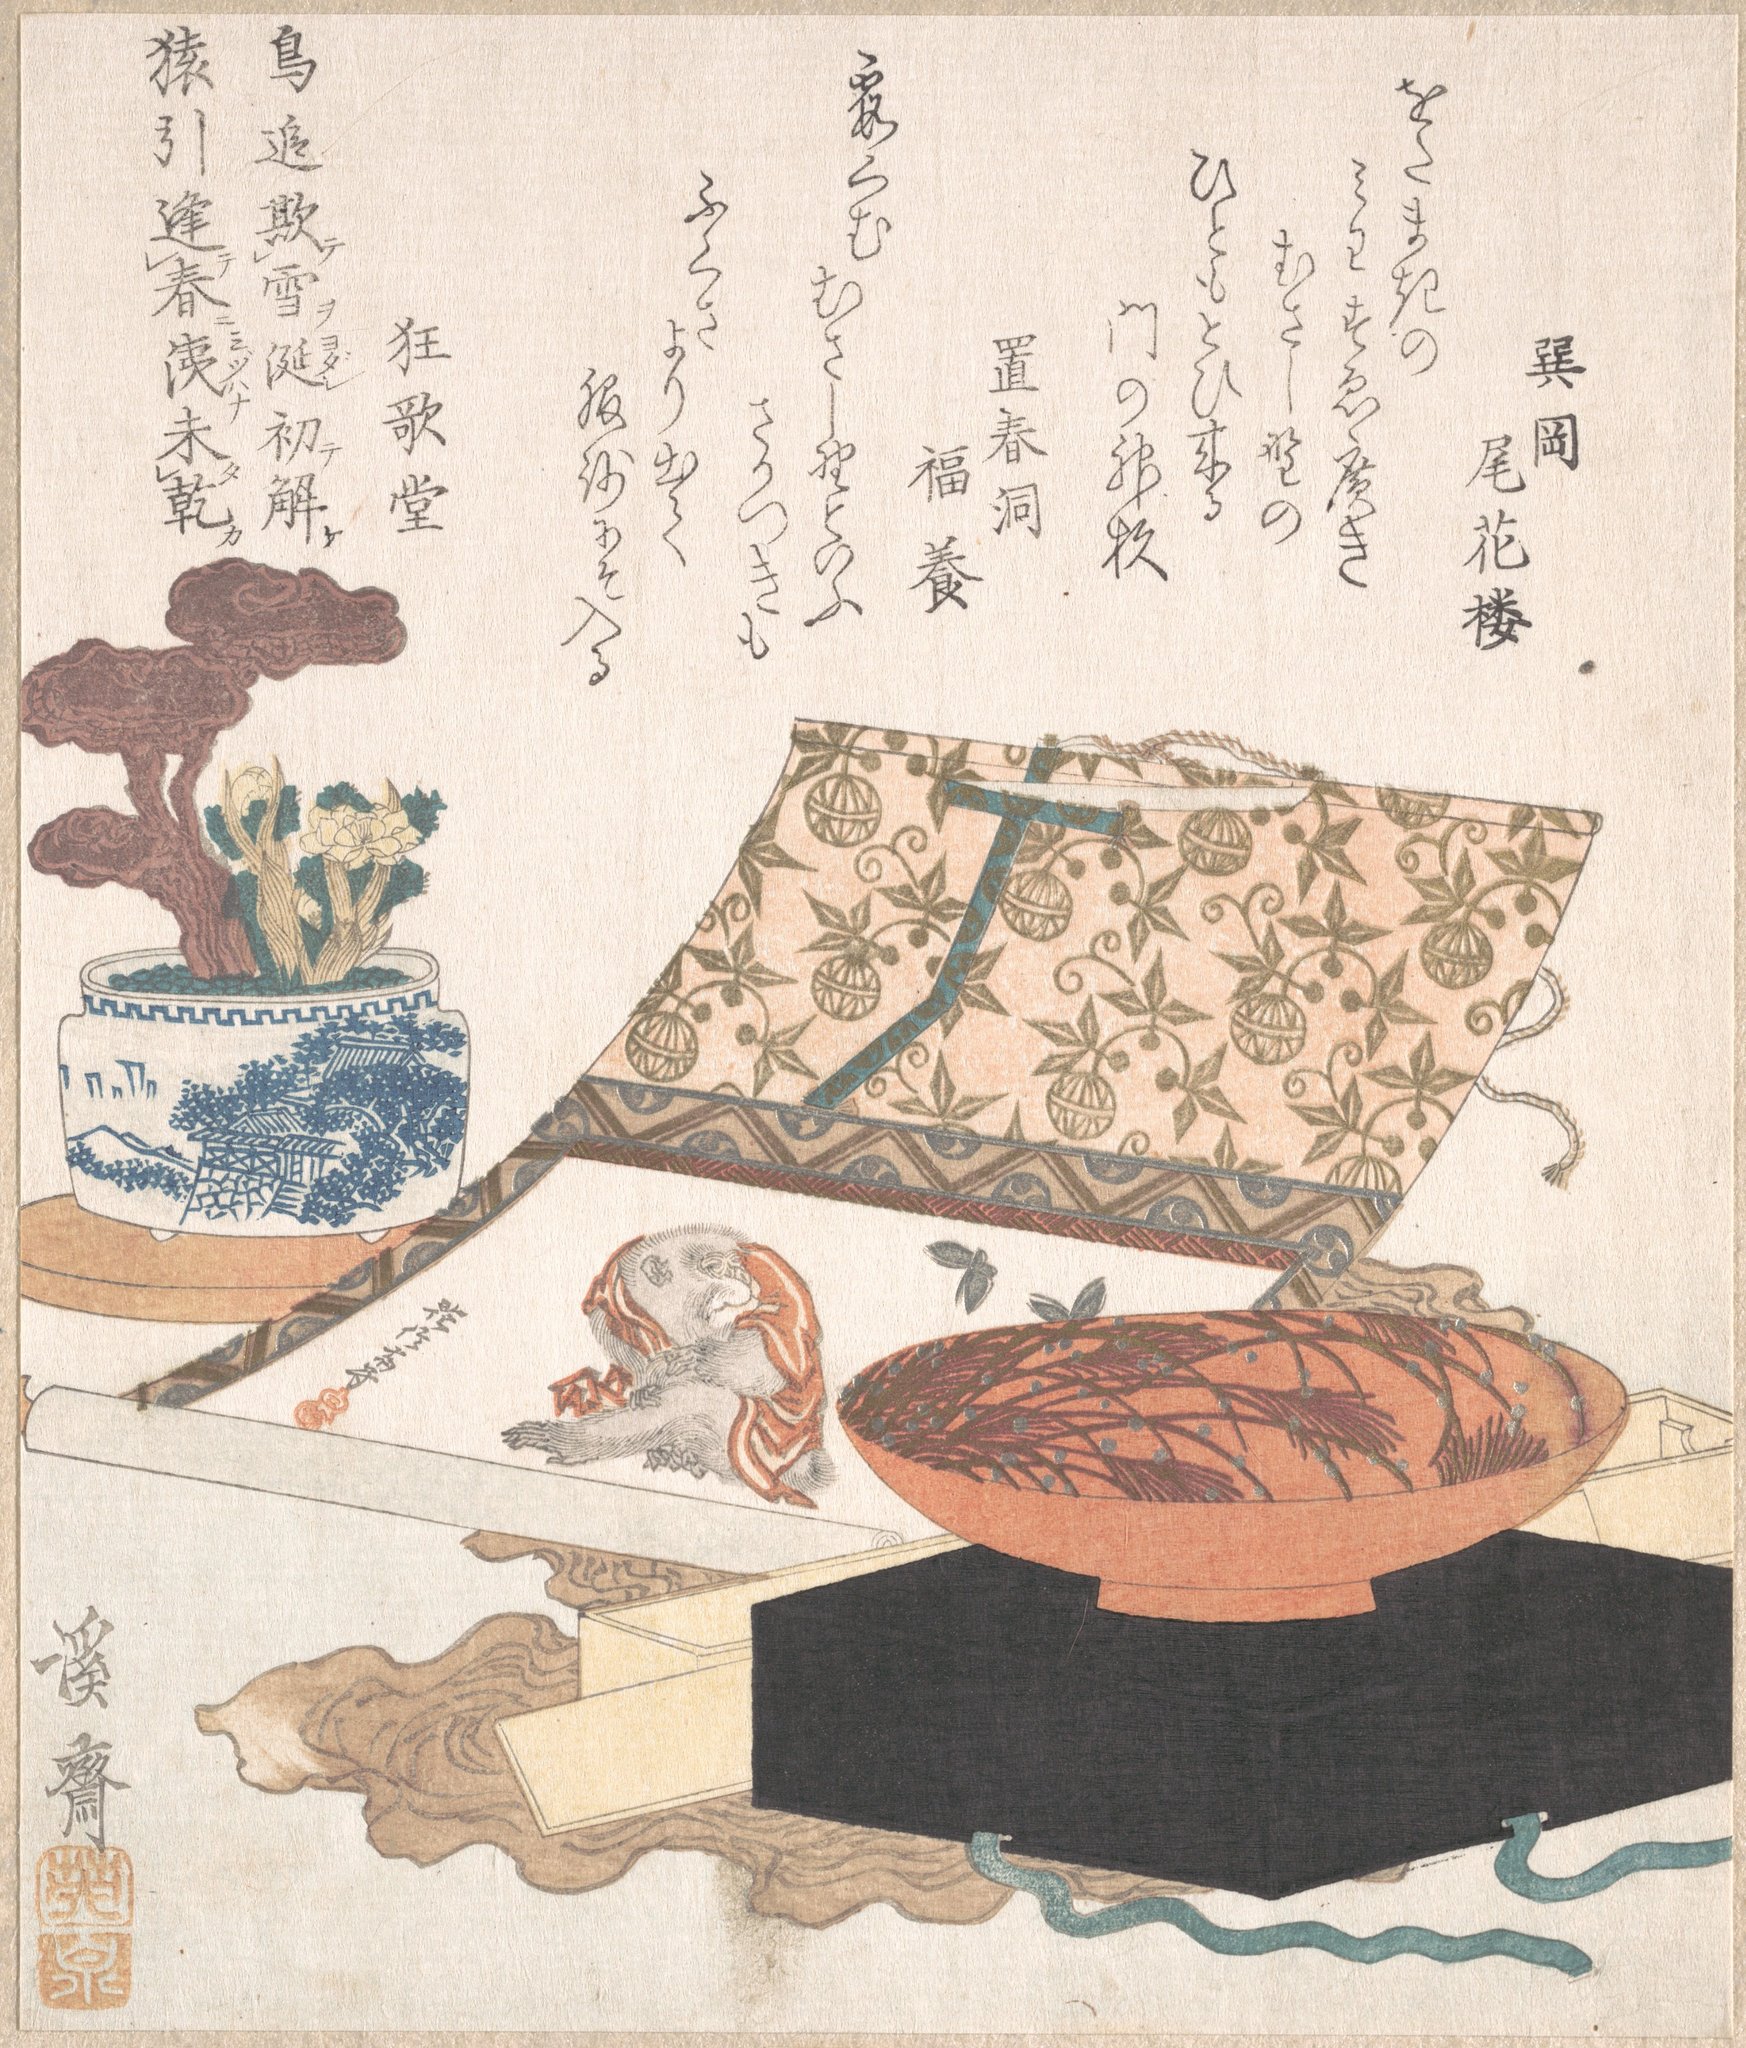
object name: print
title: Kakemono of Monkey, Wine Cup and Potted Plants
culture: japanese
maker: keisai eisen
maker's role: artist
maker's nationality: japanese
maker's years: 1790-1848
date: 1812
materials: ink, paper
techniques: surimono, woodblock print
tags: scrolls,monkeys,plants